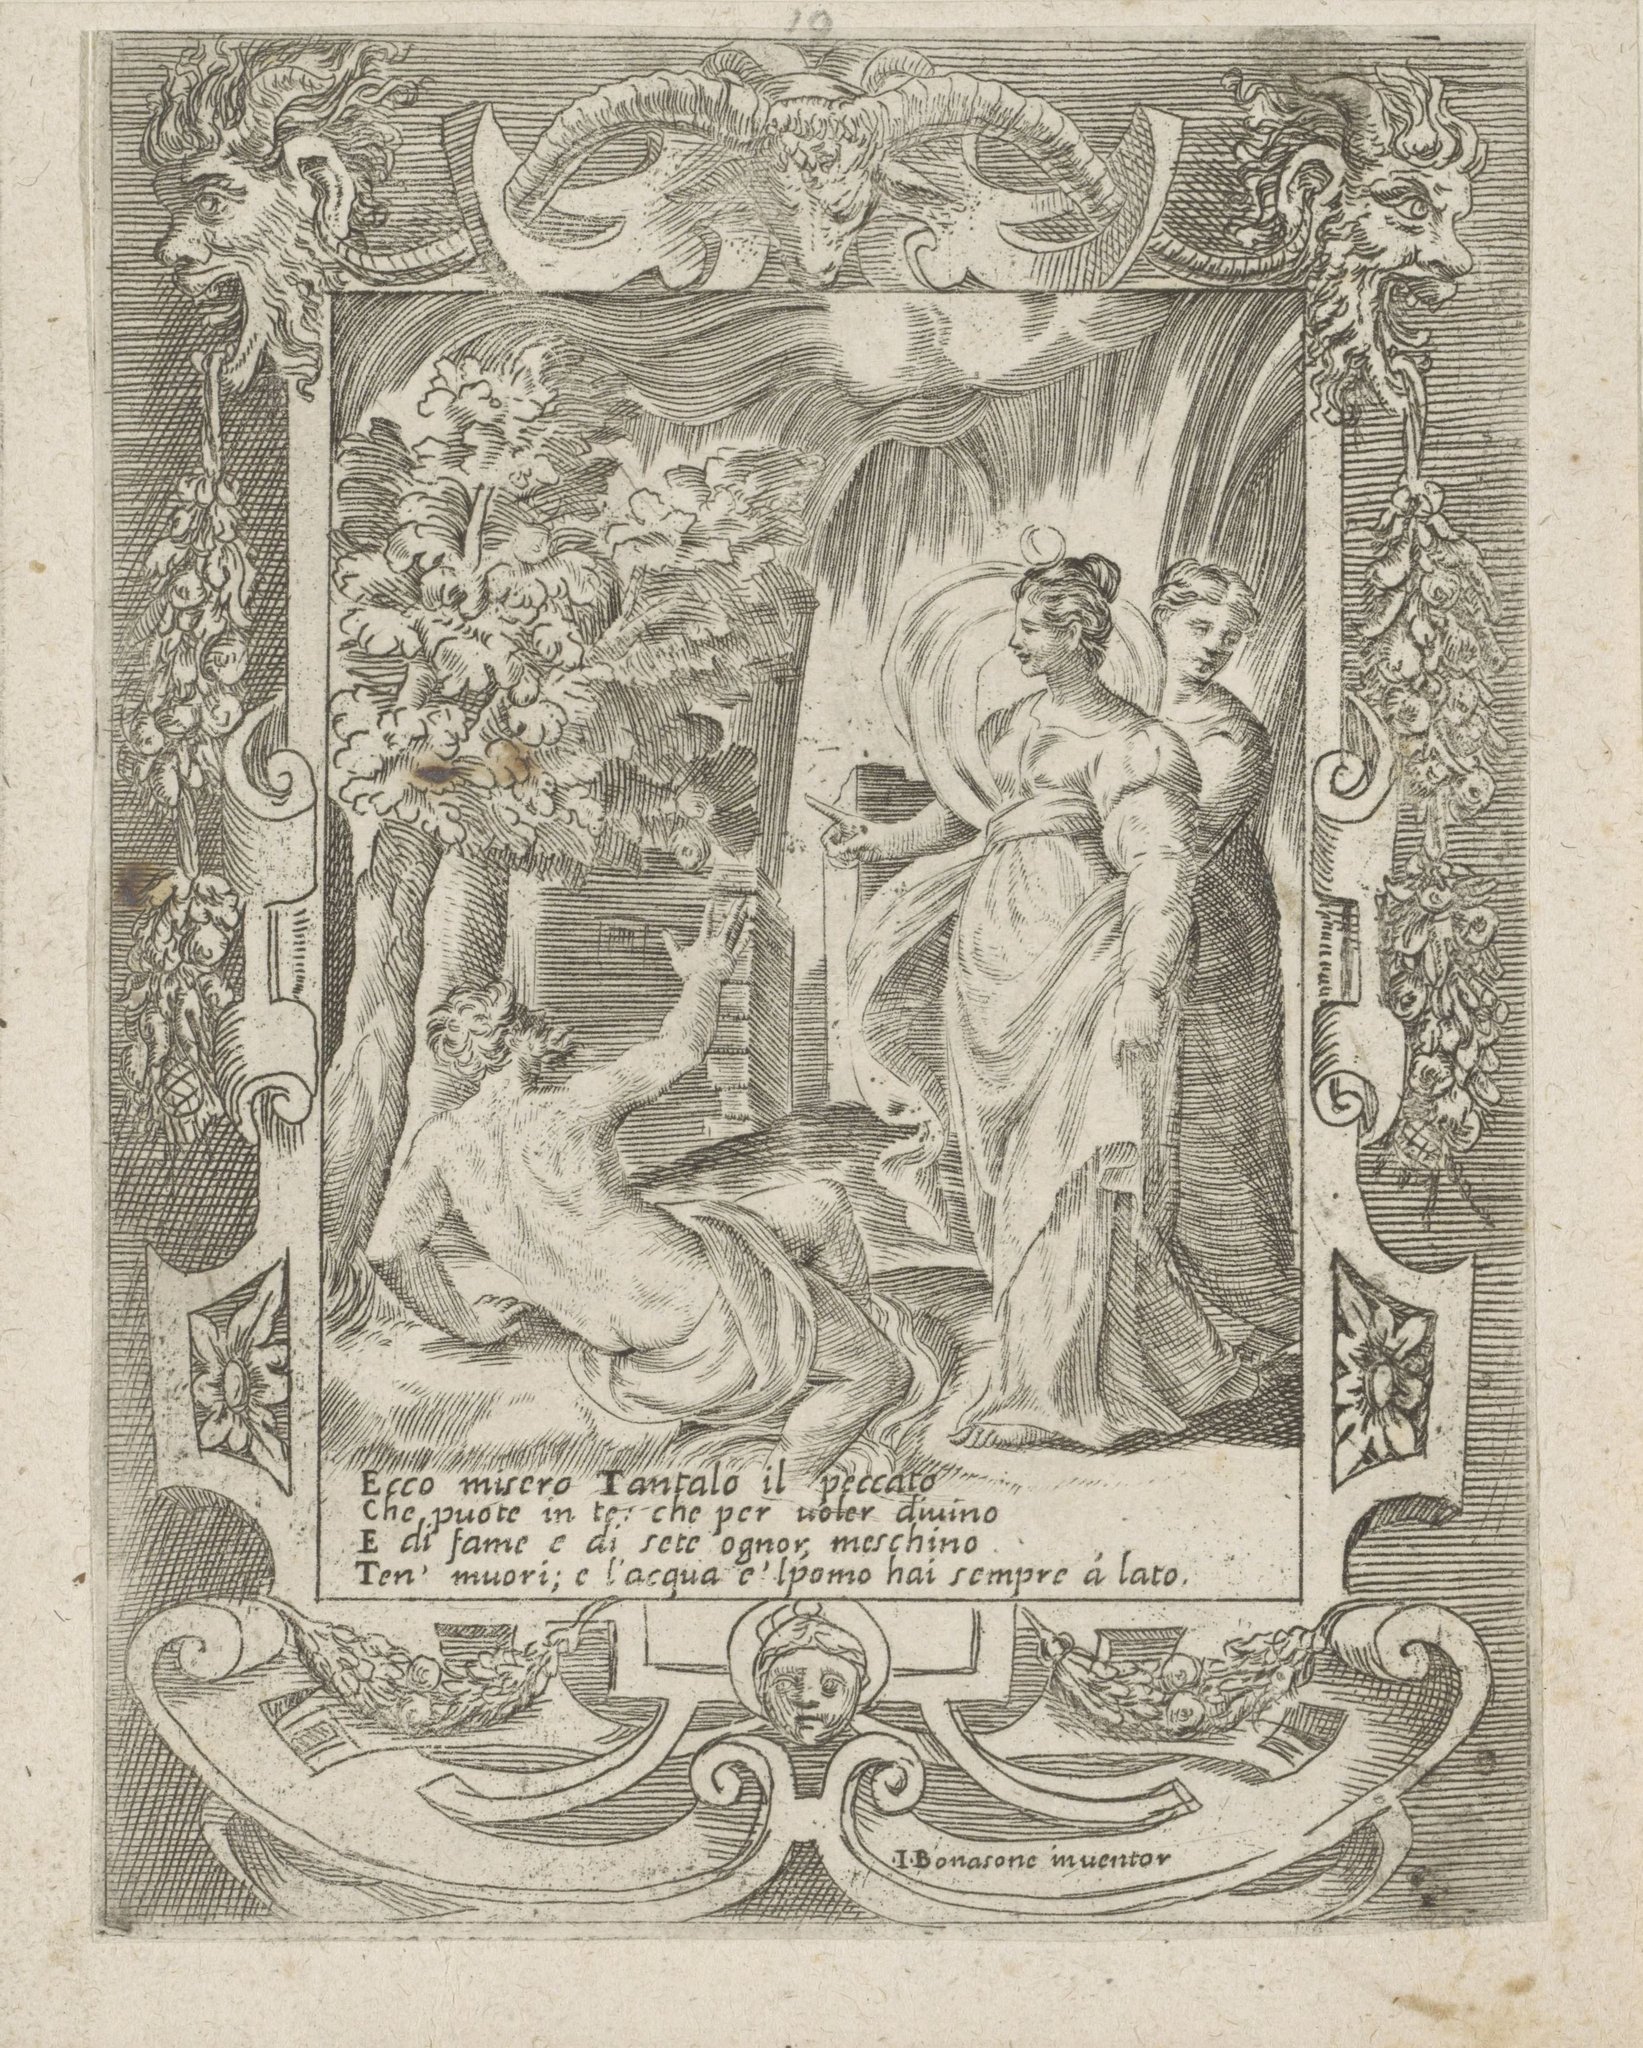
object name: print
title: Amori sdegni et gielosie di Giunone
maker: giulio bonasone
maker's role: painter, print maker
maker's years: 1510-1576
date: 1501-1580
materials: paper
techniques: engraving, etching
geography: italy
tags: (story of) diana (artemis), (story of) tantalus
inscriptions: collector's mark: Lugt 240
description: Tantalus ligt onder een boom en spreekt tegen Diana die rechts staat. Achter Diana staat een tweede vrouw. Onder een vierregelig vers in het Italiaans. De voorstelling is gevat in een sierlijst met een ramskop, maskers en guirlandes.